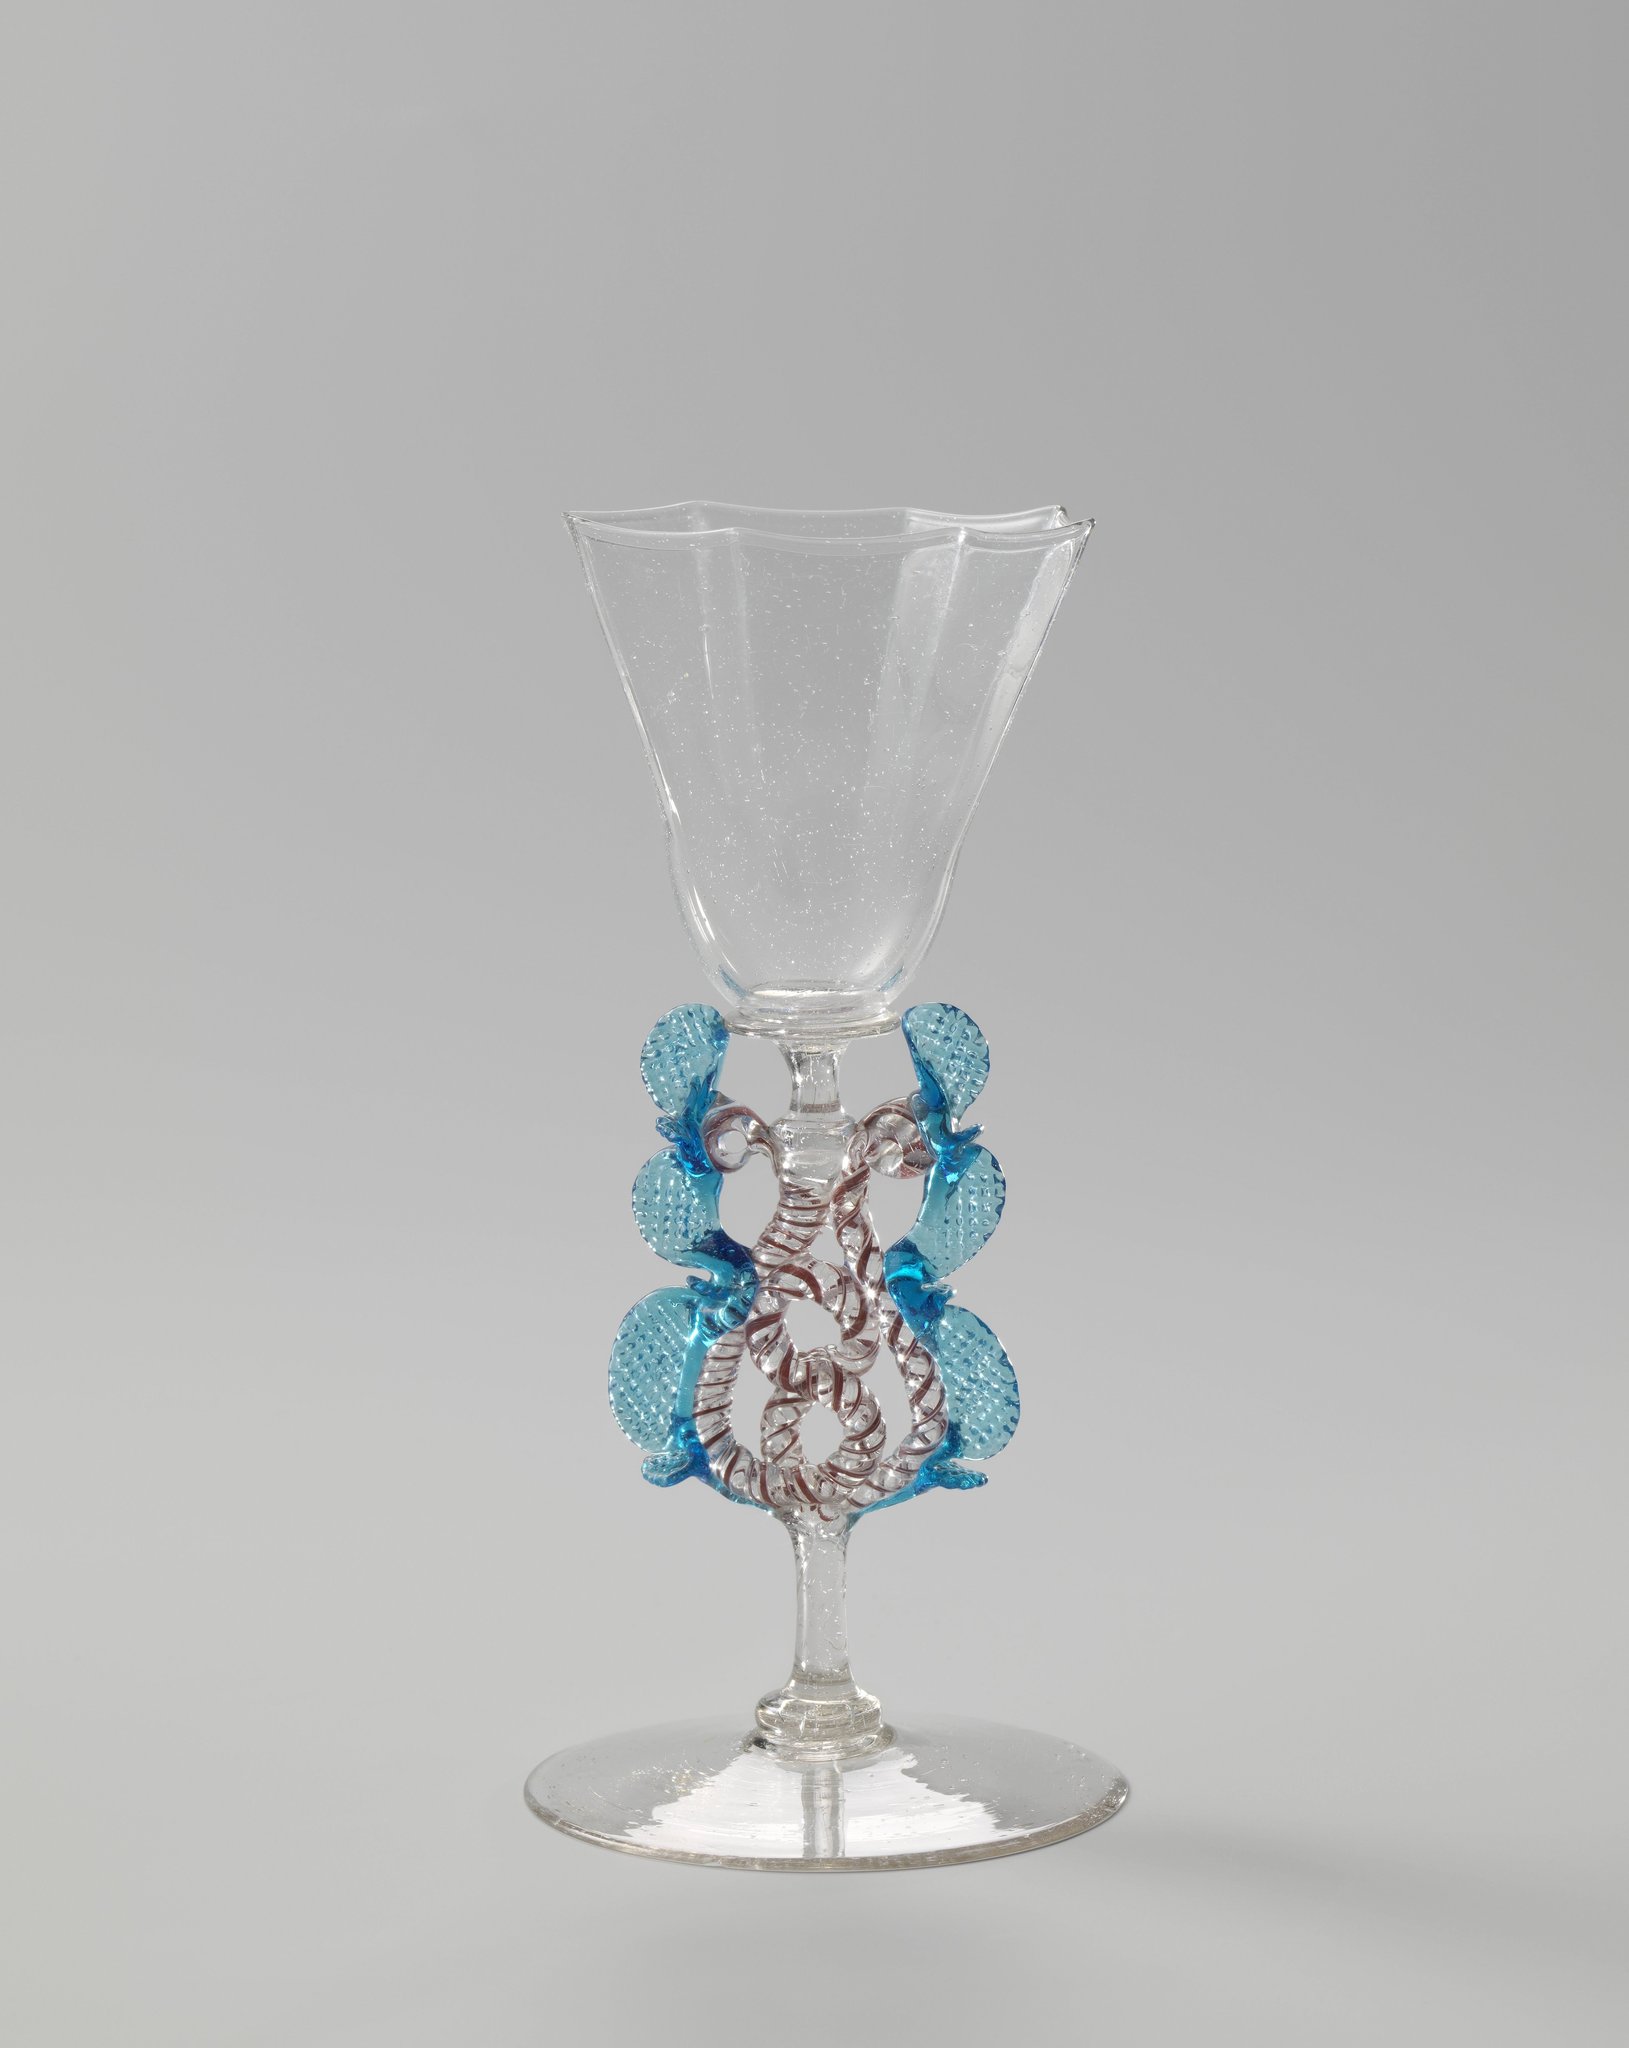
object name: vleugelglas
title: Flügelglas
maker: Anonymous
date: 1650-1700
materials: glass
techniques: façon de venise, glassblowing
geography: netherlands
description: Platte voet. De stam opgebouwd uit een getordeerde in lussen gelegde staaf met rode en witte draden. Ter weerskanten drie geknepen kammen. Conische kelk overgaand in een achthoek.